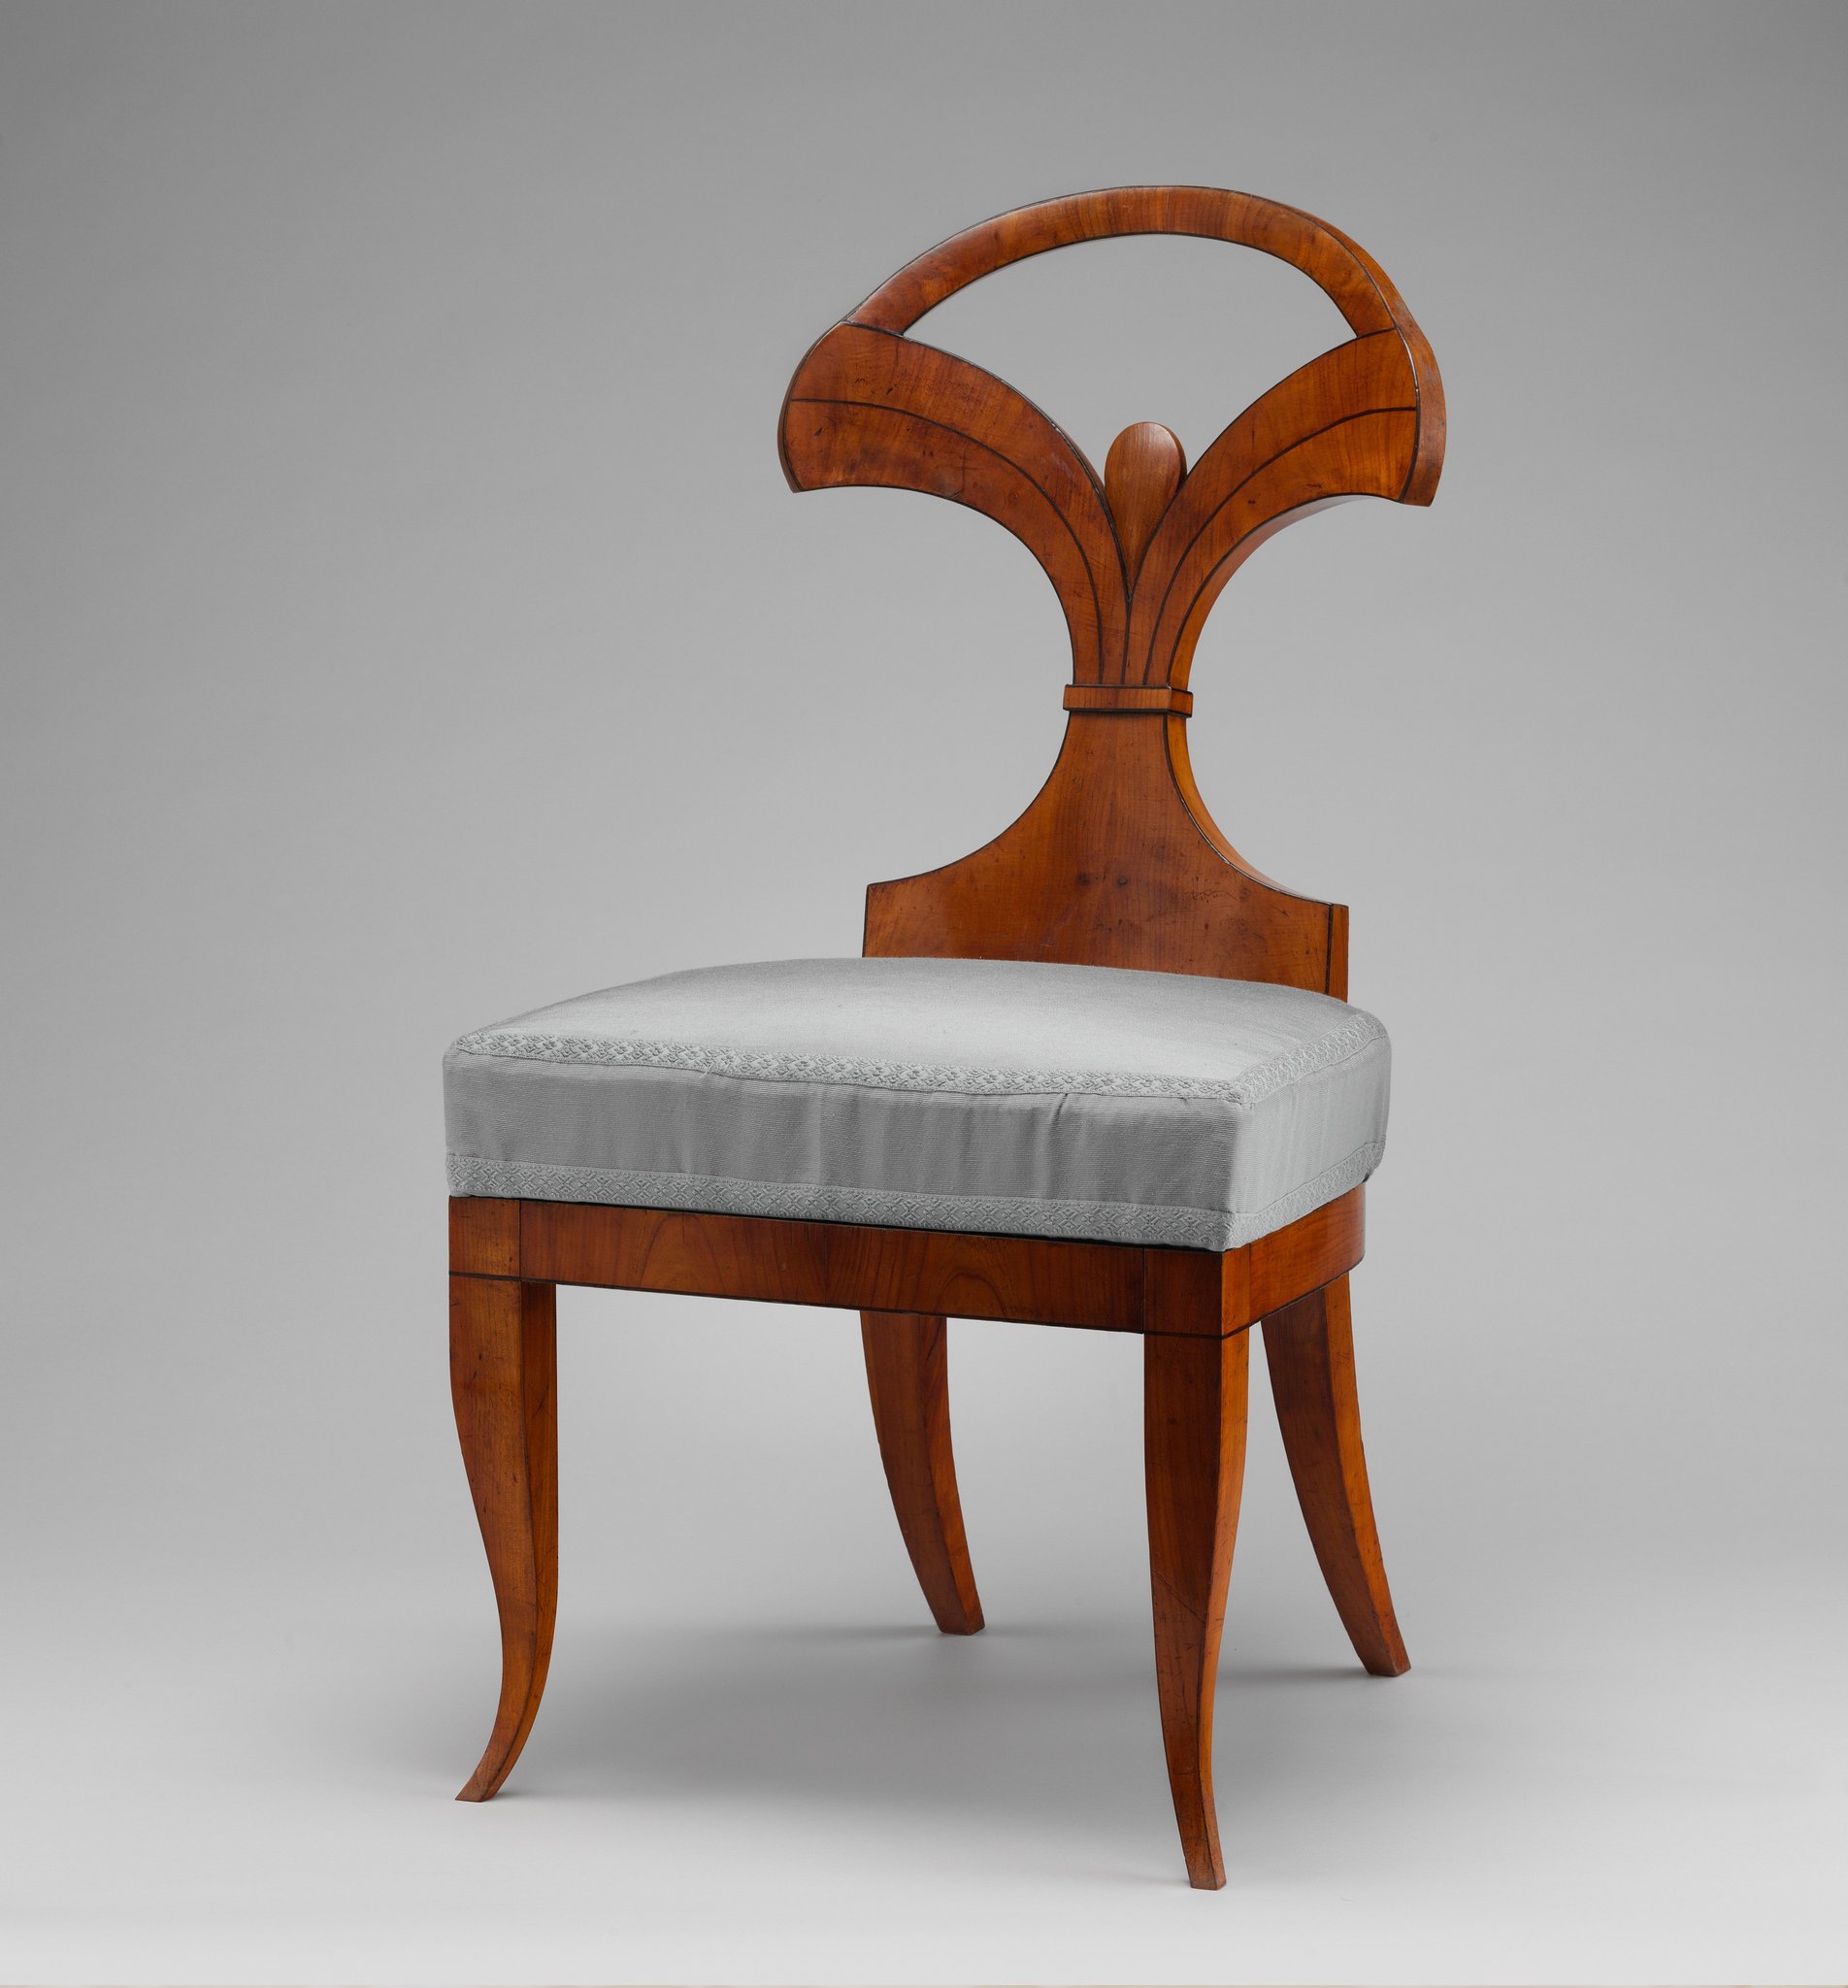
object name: side chair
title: Side chair (one of a pair)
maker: josef danhauser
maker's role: maker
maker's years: 1780-1829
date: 1815-1820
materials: wood, silk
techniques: veneering